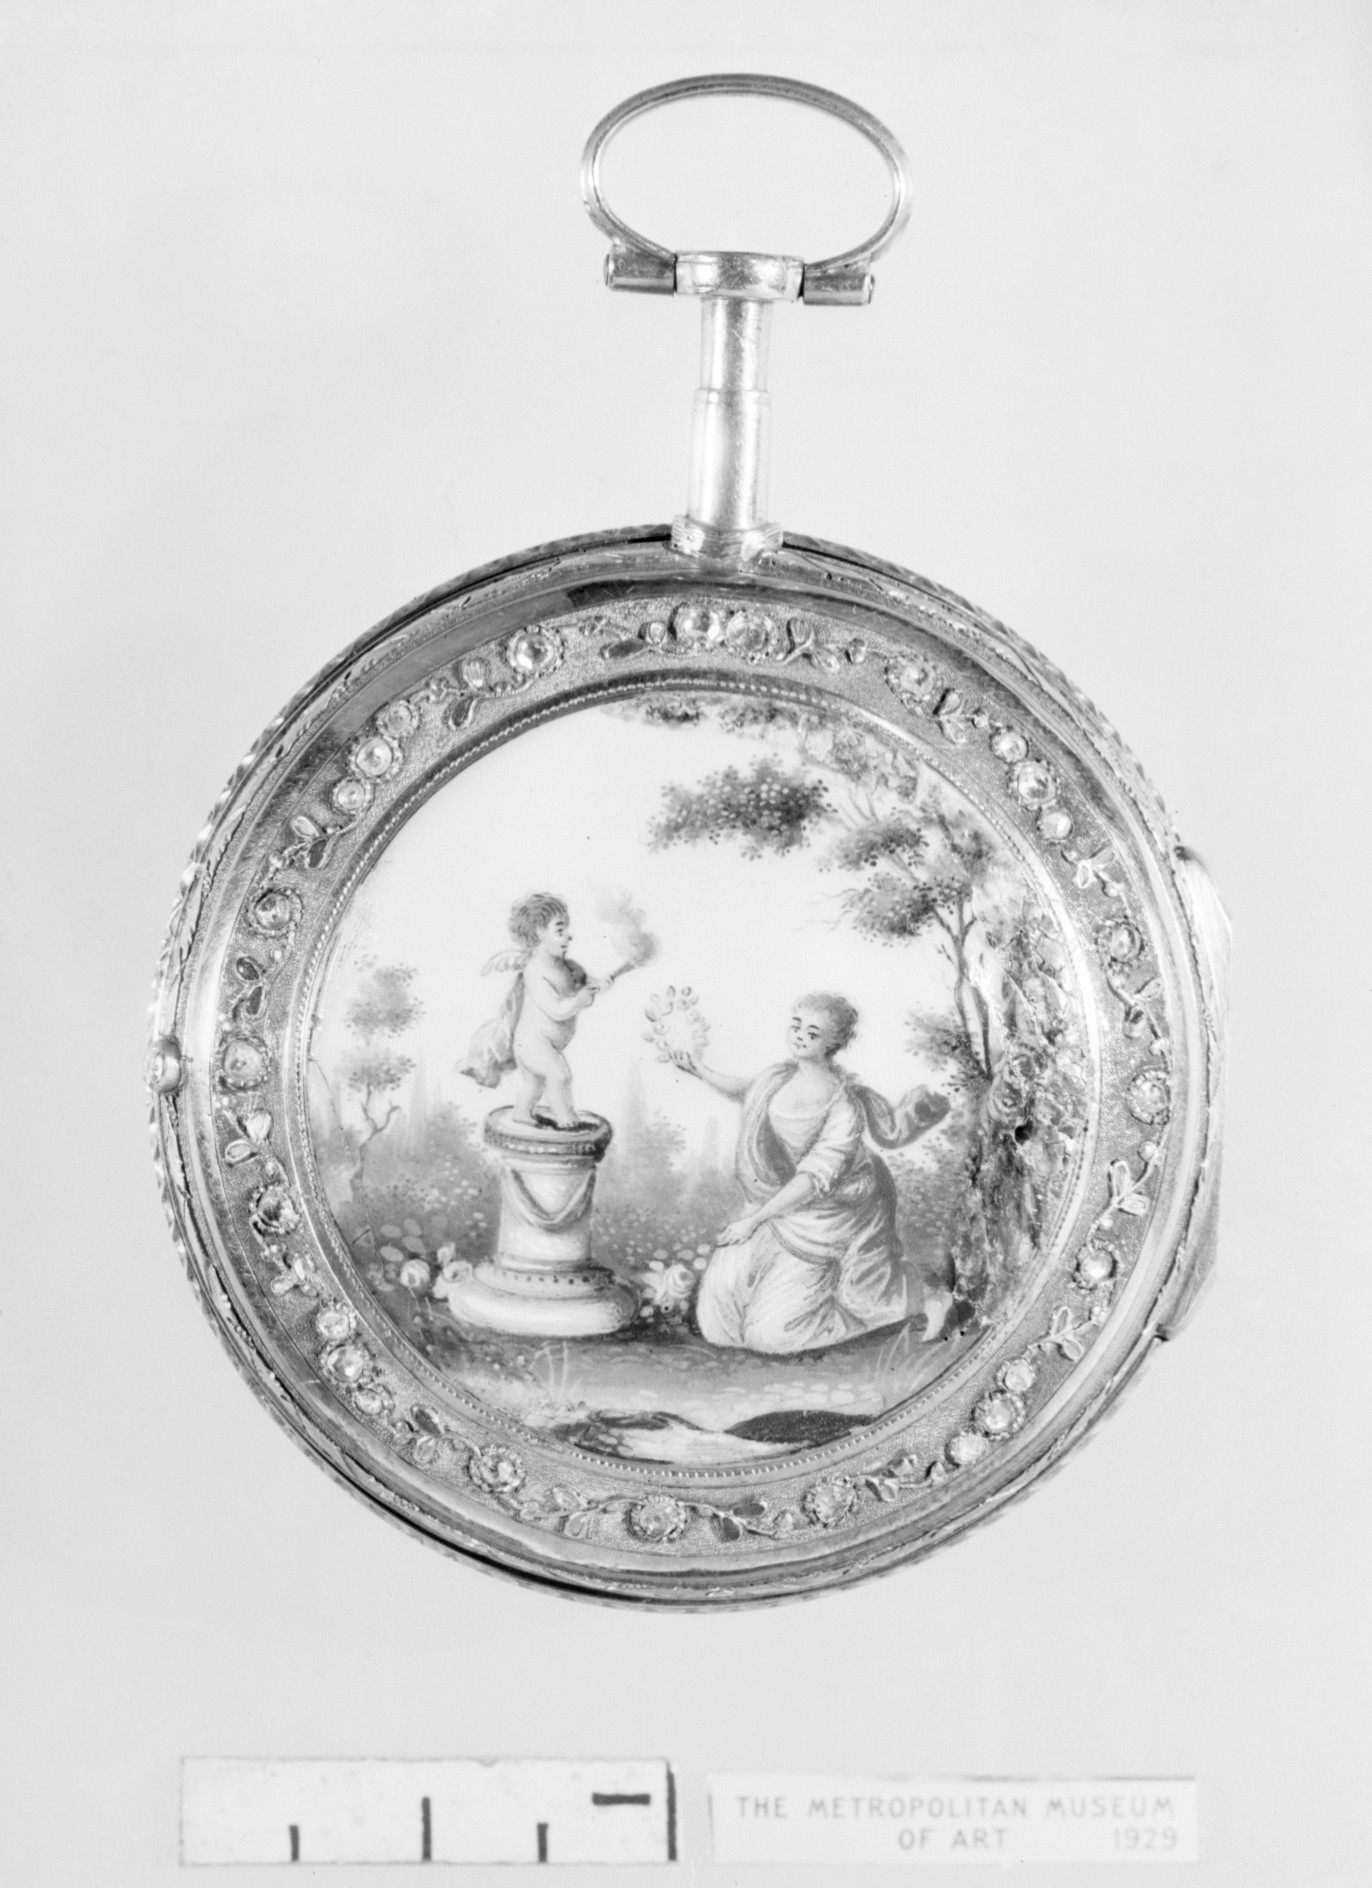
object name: watch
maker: ferdinand berthoud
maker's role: maker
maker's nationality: french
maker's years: 1727-1807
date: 1767-1800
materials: diamond, gold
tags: women,putti